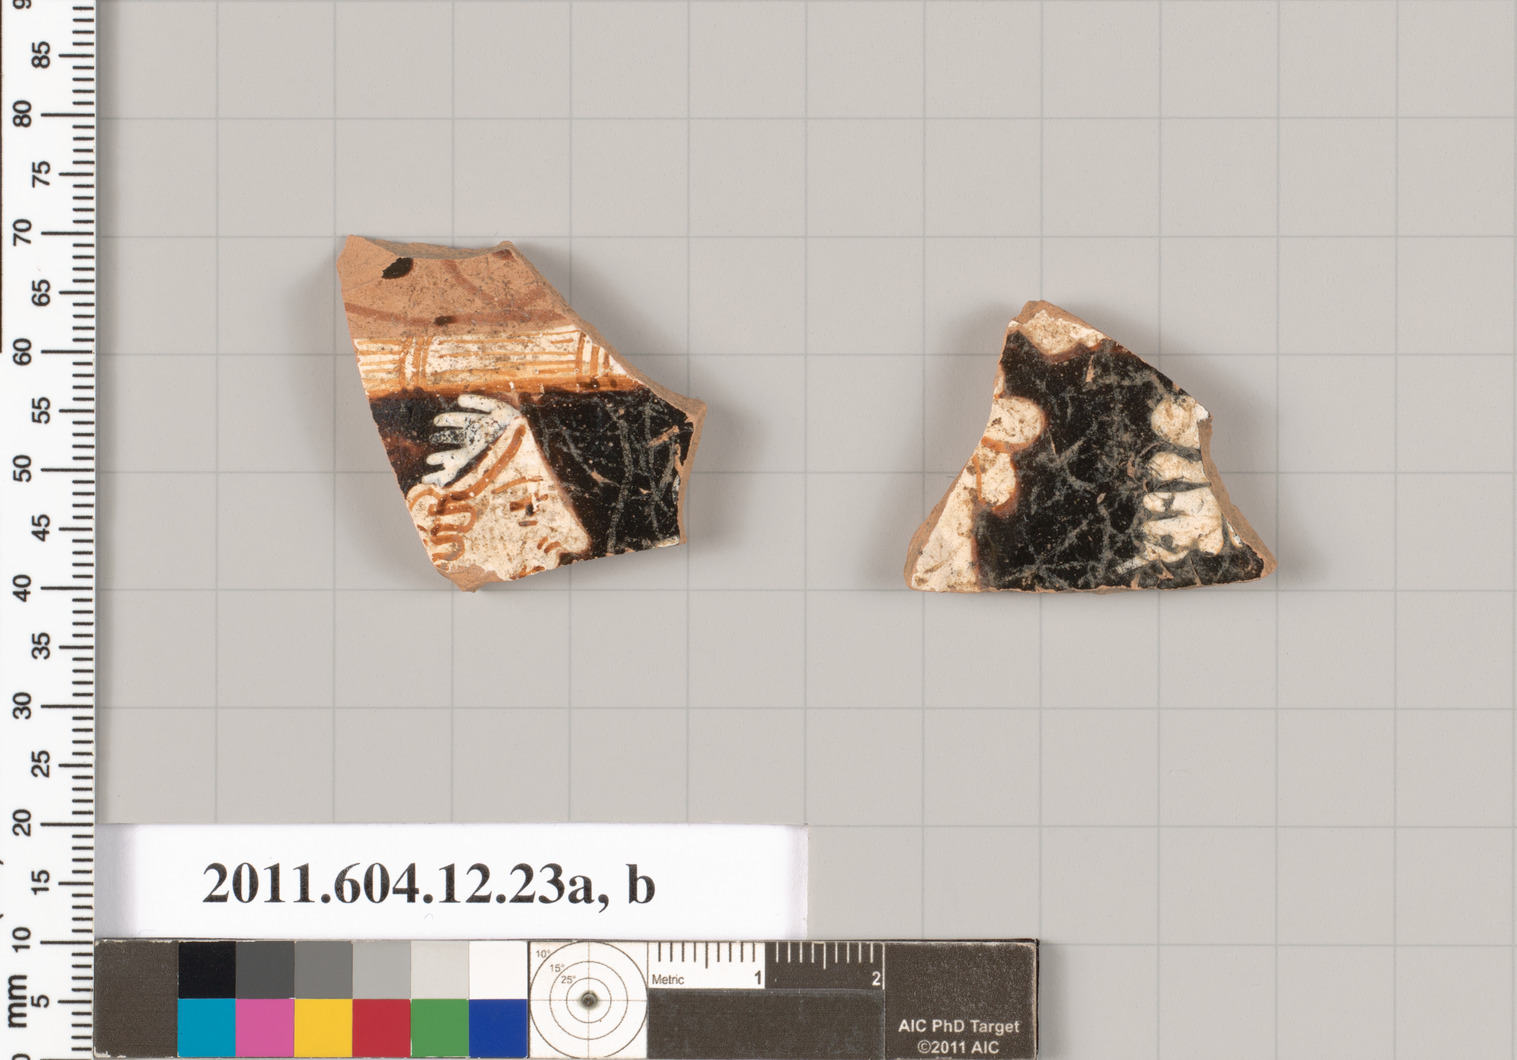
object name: lekythos fragment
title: Terracotta fragments of a lekythos (oil flask)?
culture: greek, attic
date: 350-301 BCE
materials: terracotta